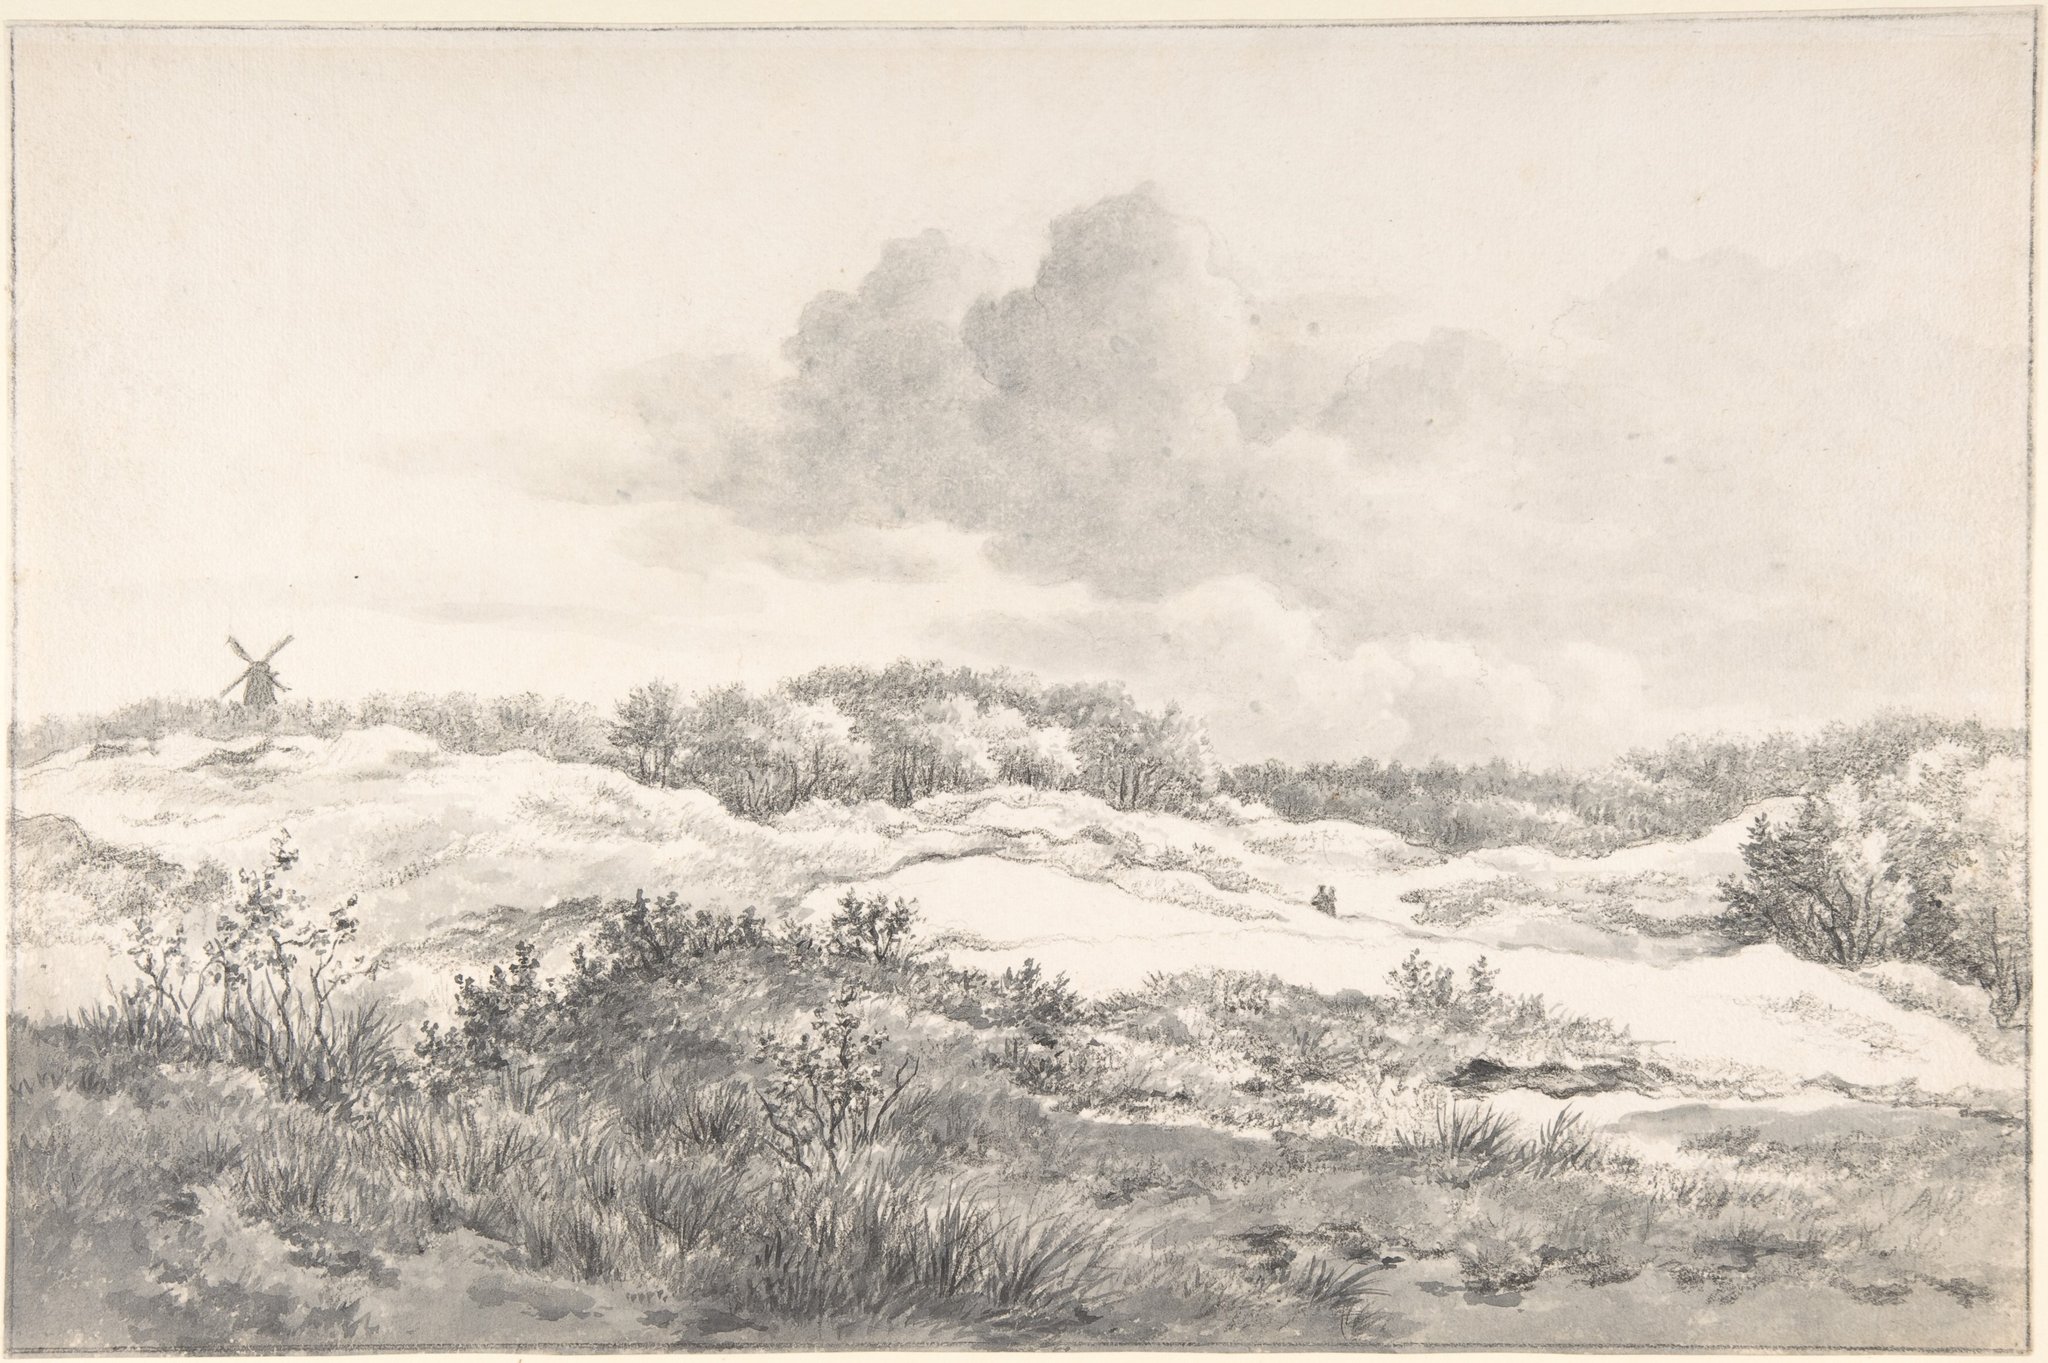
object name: drawing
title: Wooded Dune Landscape near Haarlem, with Windmill and a Pair of Figures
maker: gerrit jan michaëlis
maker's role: artist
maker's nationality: dutch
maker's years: 1775-1857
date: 1767-1866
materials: chalk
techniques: wash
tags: human figures,windmills,landscapes